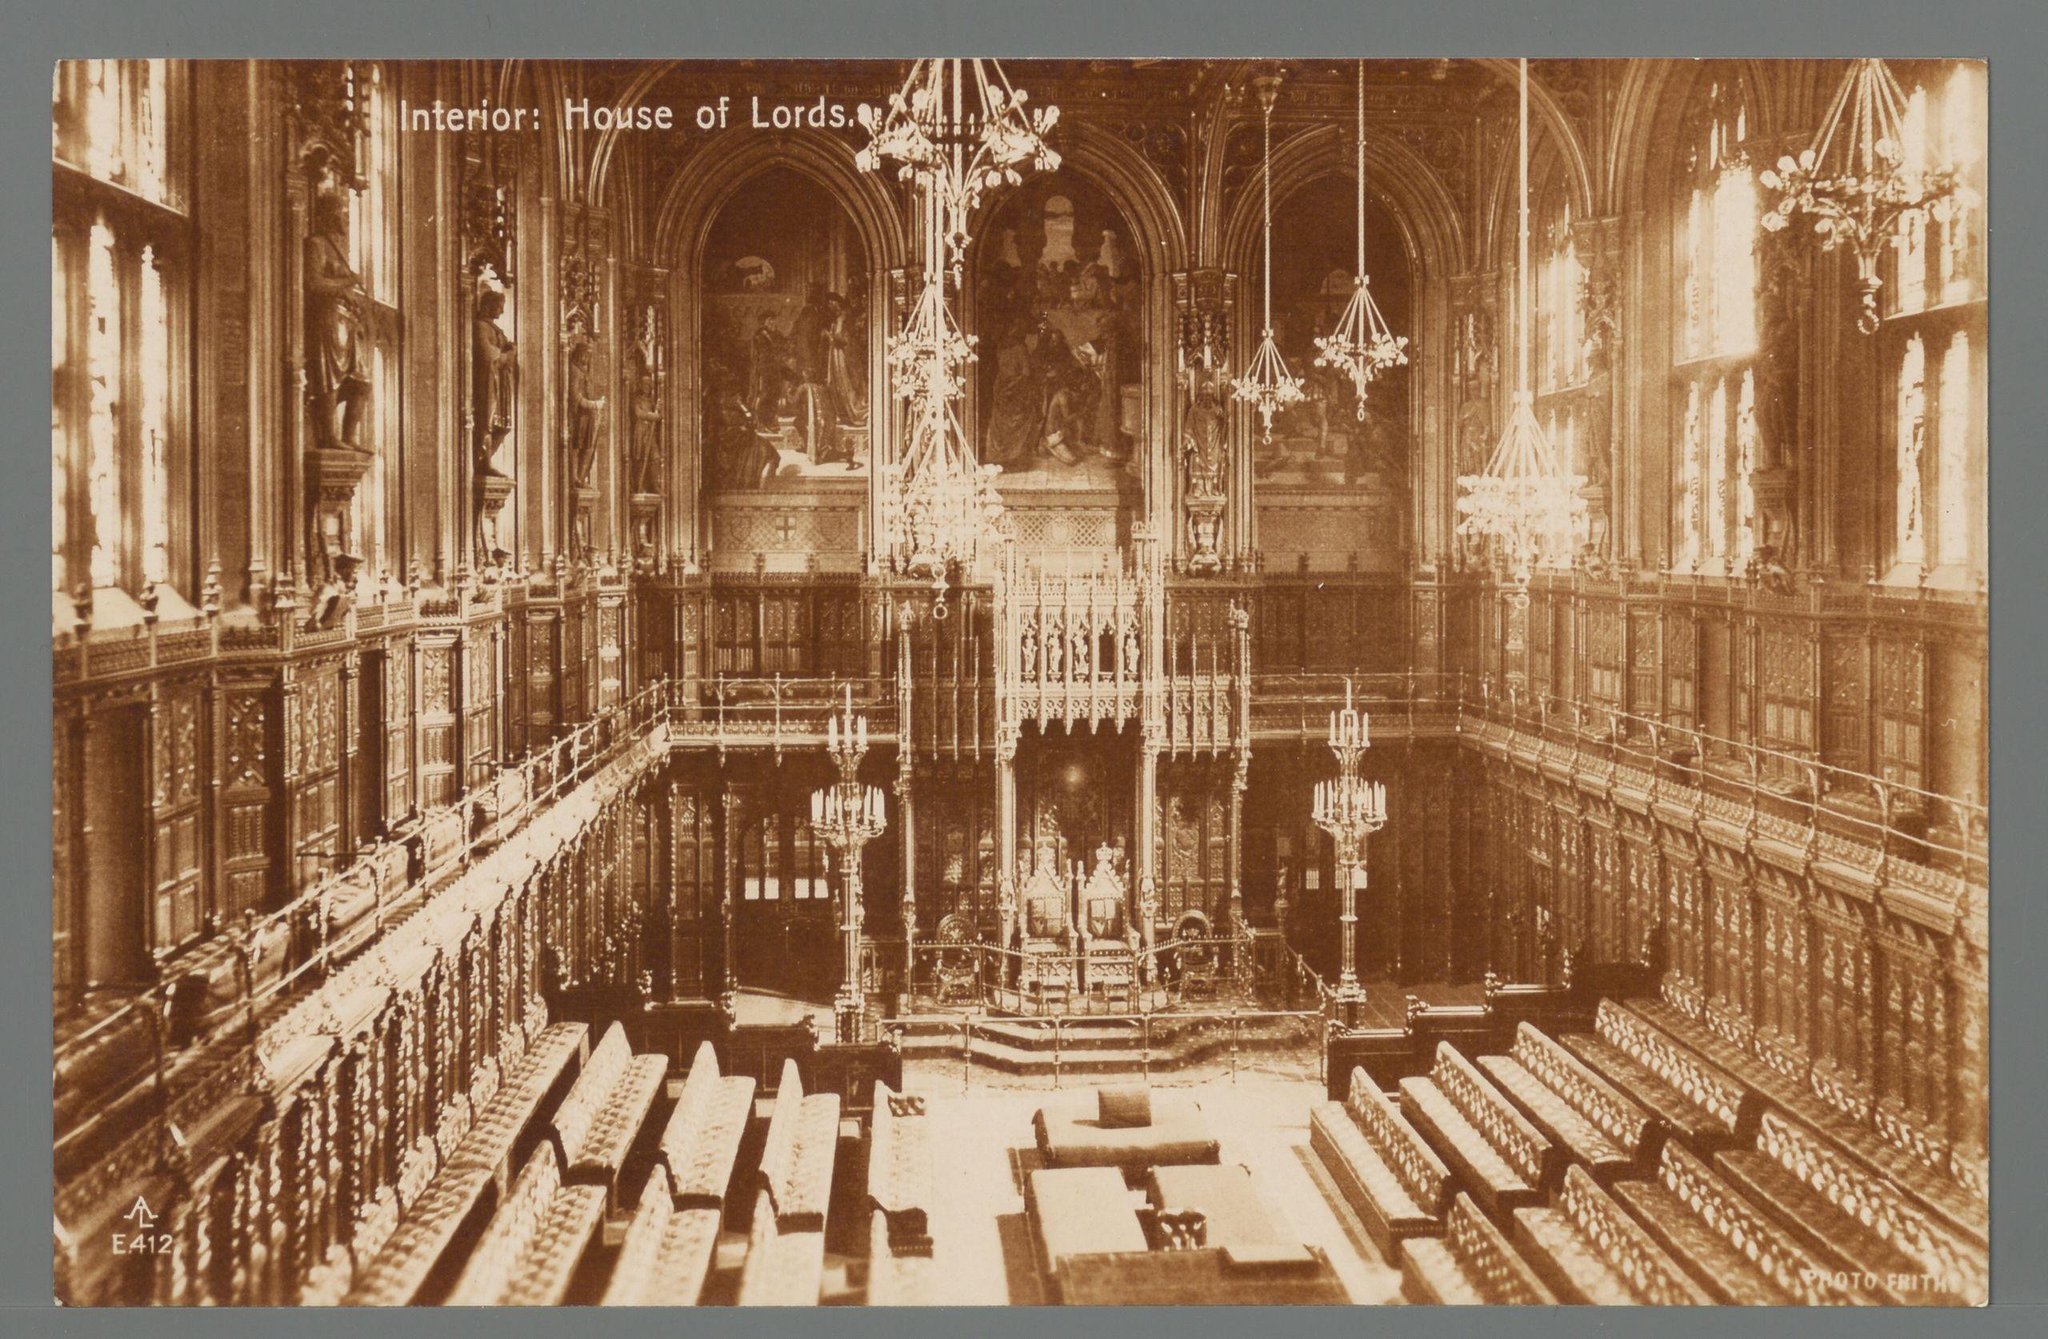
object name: photograph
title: Interior: House of Lords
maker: Anonymous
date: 1902-1940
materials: paper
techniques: gelatin silver print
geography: saxony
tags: interior of the house